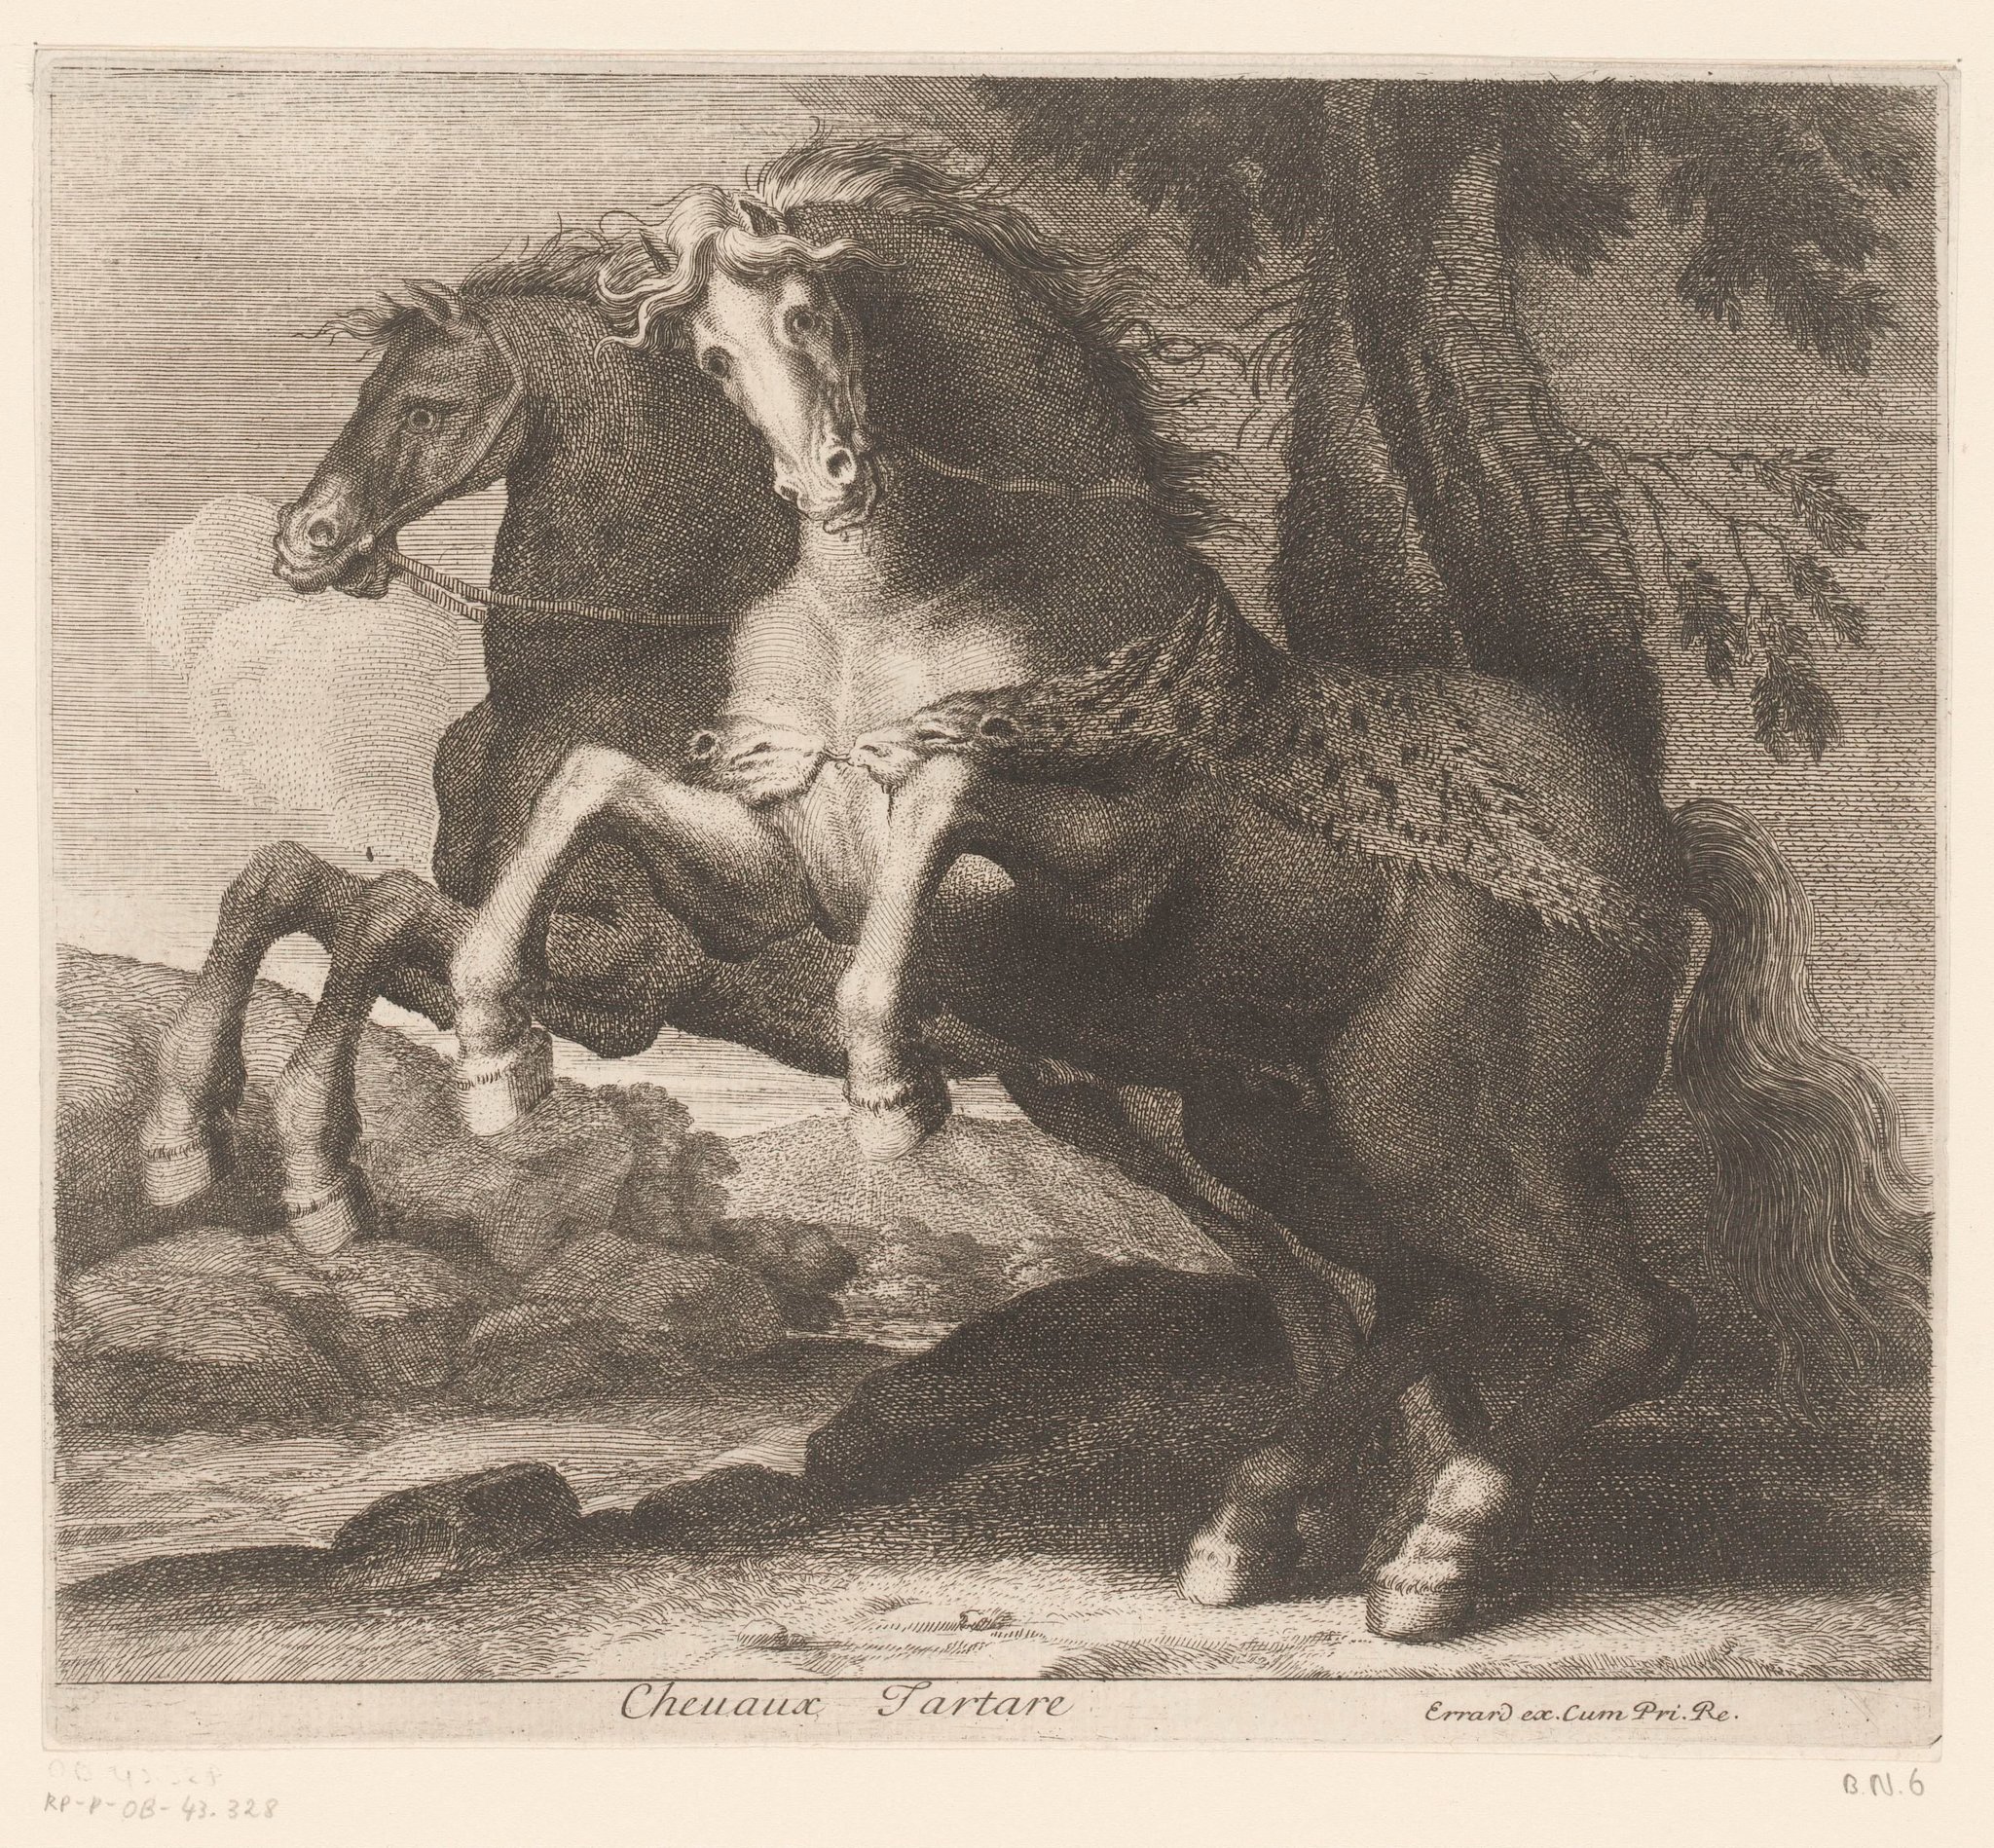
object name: print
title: Chevaux Tartare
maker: charles ii errard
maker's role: print maker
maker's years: 1601-1689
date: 1616-1689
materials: paper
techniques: engraving, etching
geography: paris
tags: rearing (horse in motion)